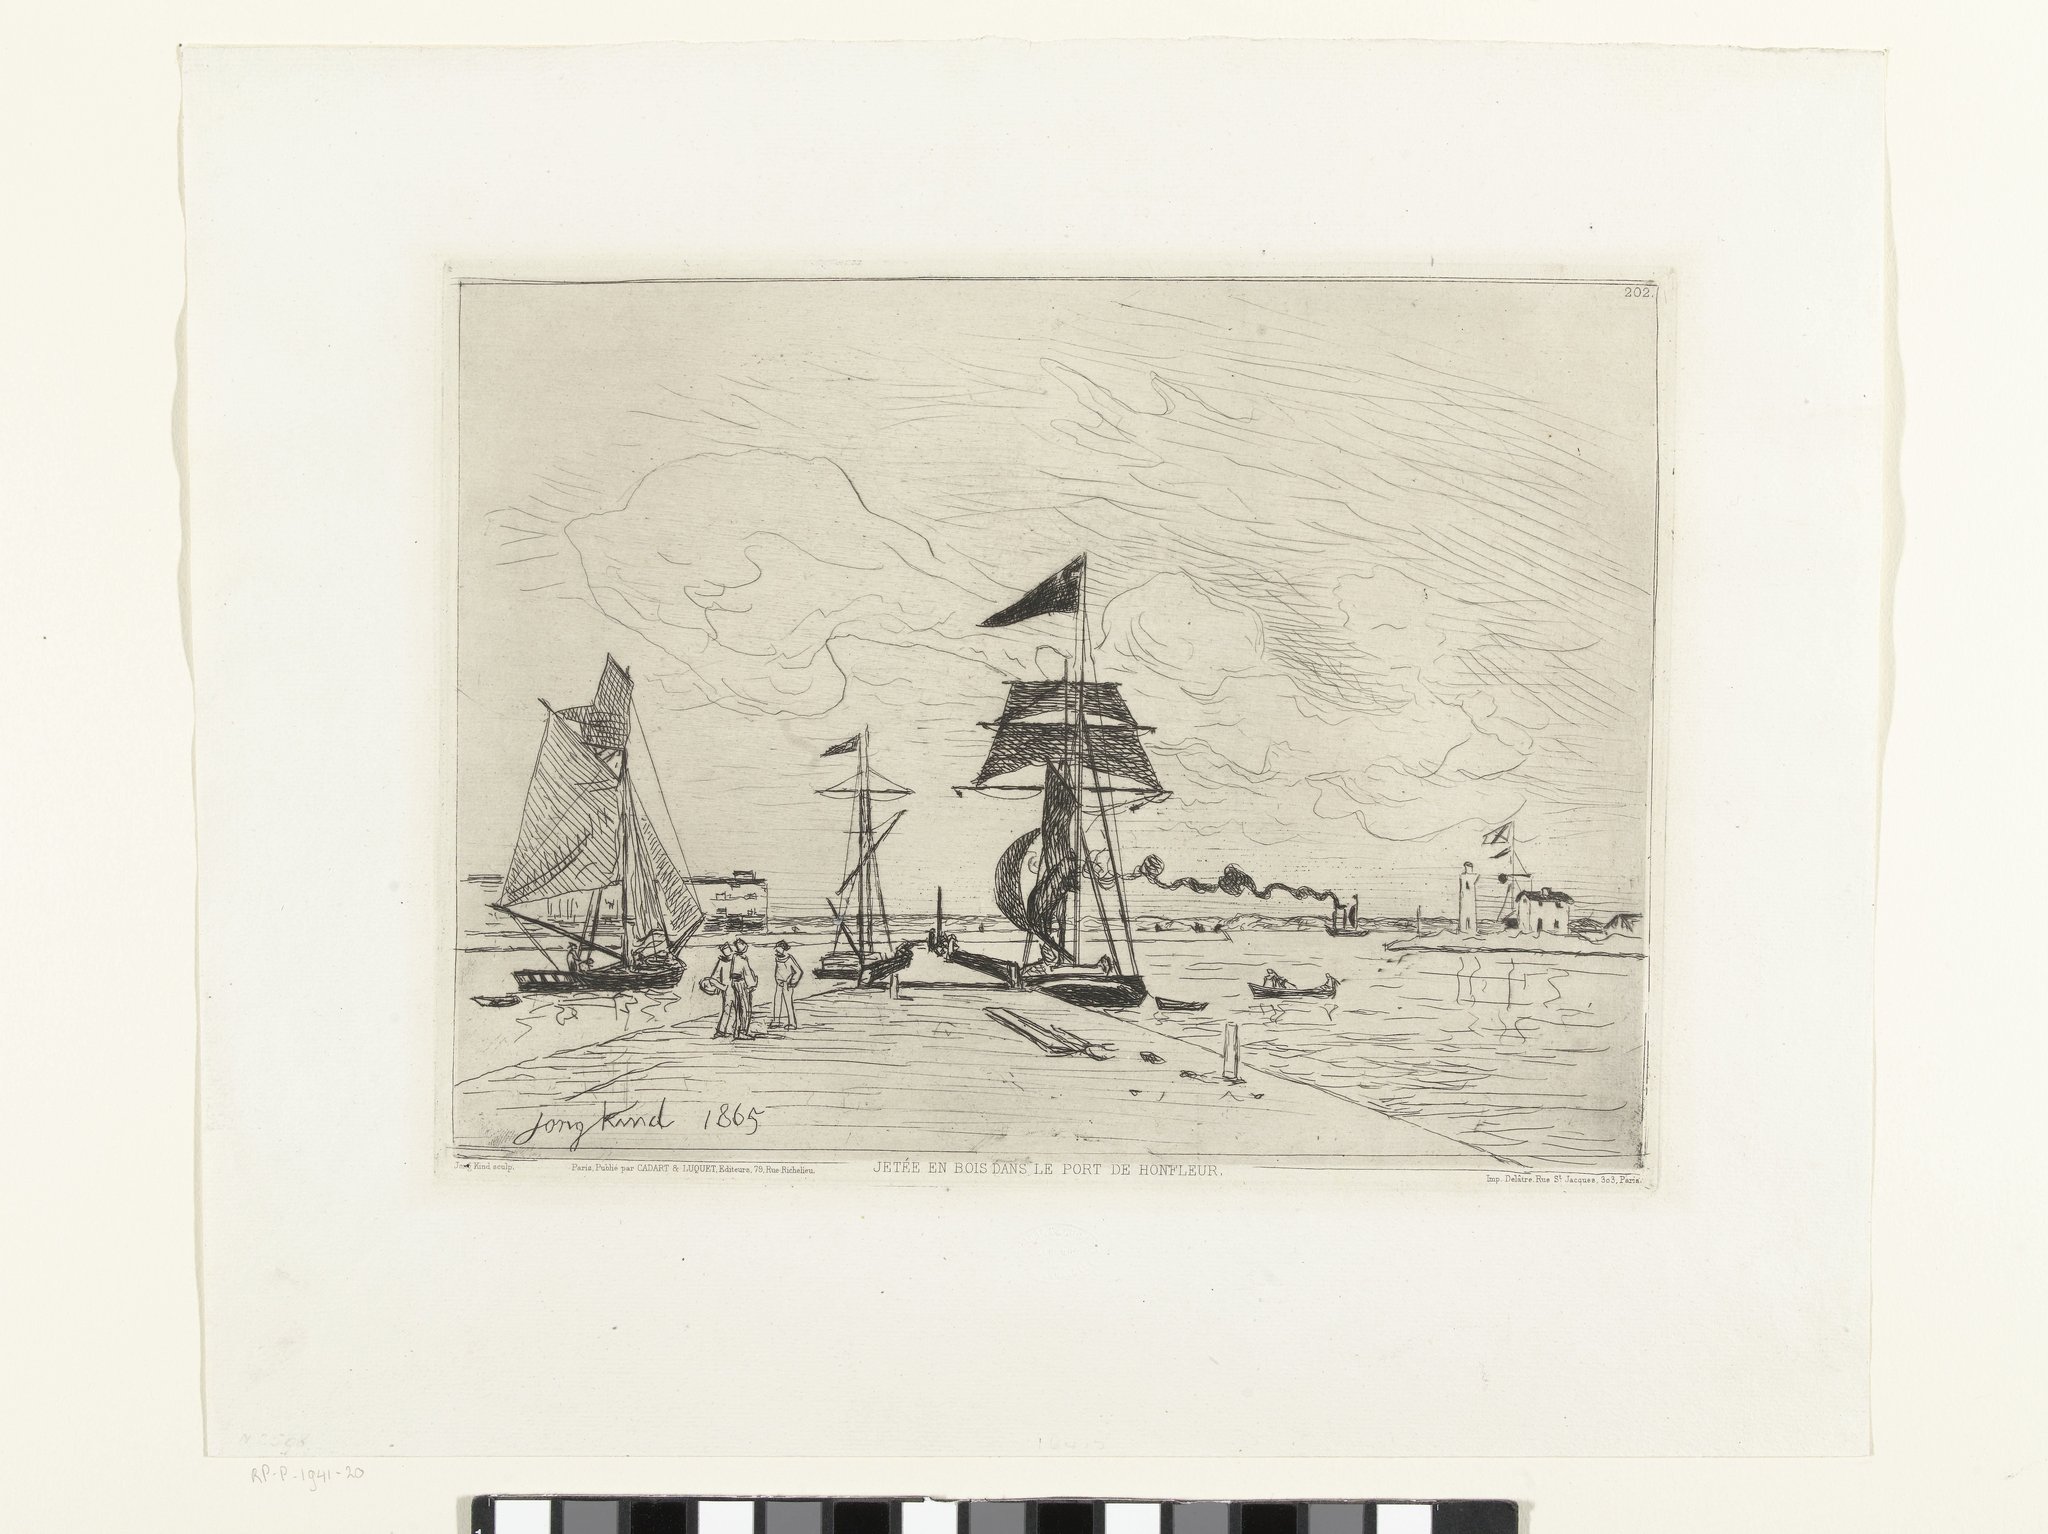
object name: print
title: Aanlegsteiger bij Honfleur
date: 1865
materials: paper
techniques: etching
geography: paris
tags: harbour, ships (in general)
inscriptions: collector's mark: Lugt 2228a, collector's mark: Lugt 2760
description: Een steiger in de haven van Honfleur, waaromheen drie zeilschepen liggen. Rechts op de achtergrond een vuurtoren, links een aantal huizen.